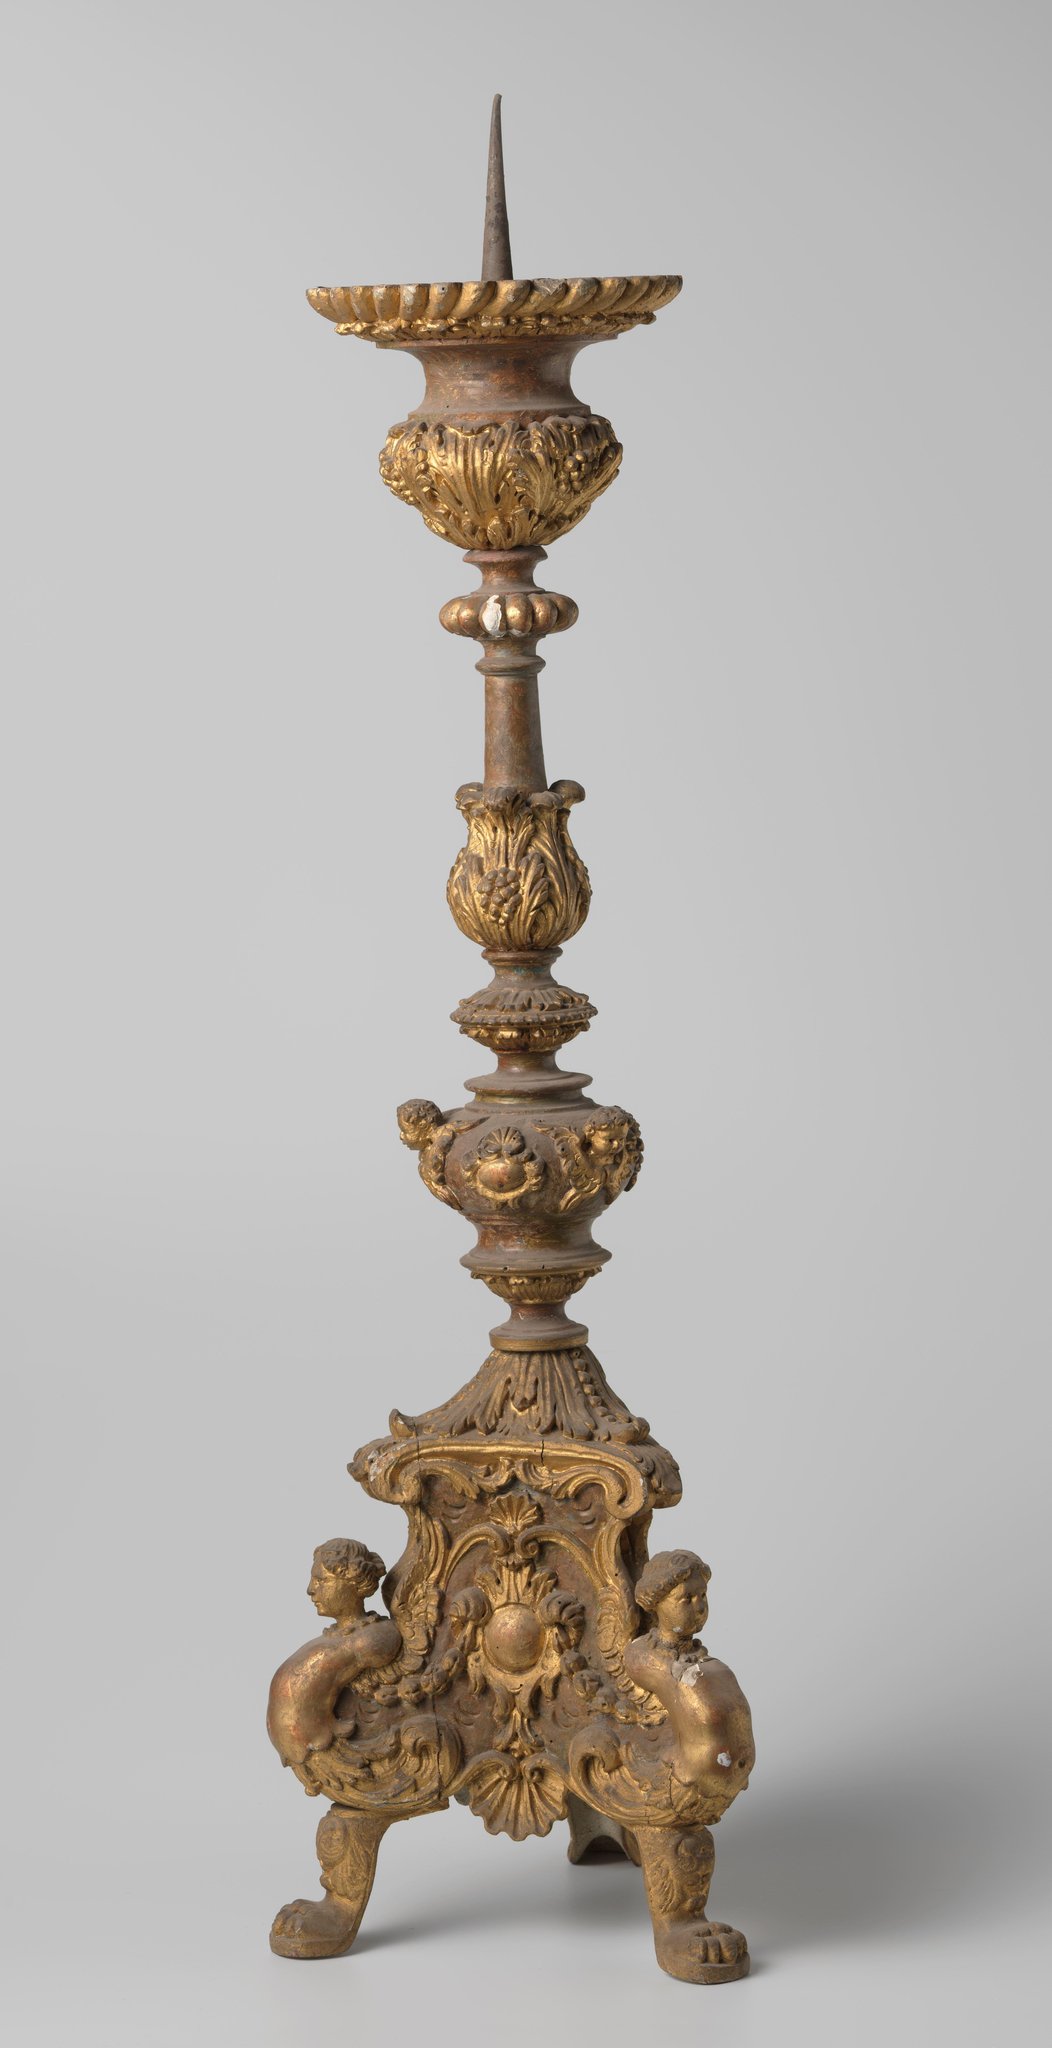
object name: kerkkandelaar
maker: Anonymous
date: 1685-1700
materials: wood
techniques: gilding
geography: northern netherlands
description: Grote houten gebeeldhouwde kerkkandelaar, staande op drie poten, waarboven vrouwenfiguren zijn aangebracht. De knoop is versierd met gevleugelde engelenkoppen. Het beeldhouwwerk is verguld, op een witte grond. Een pen is aanwezig om de kaars te draaien.